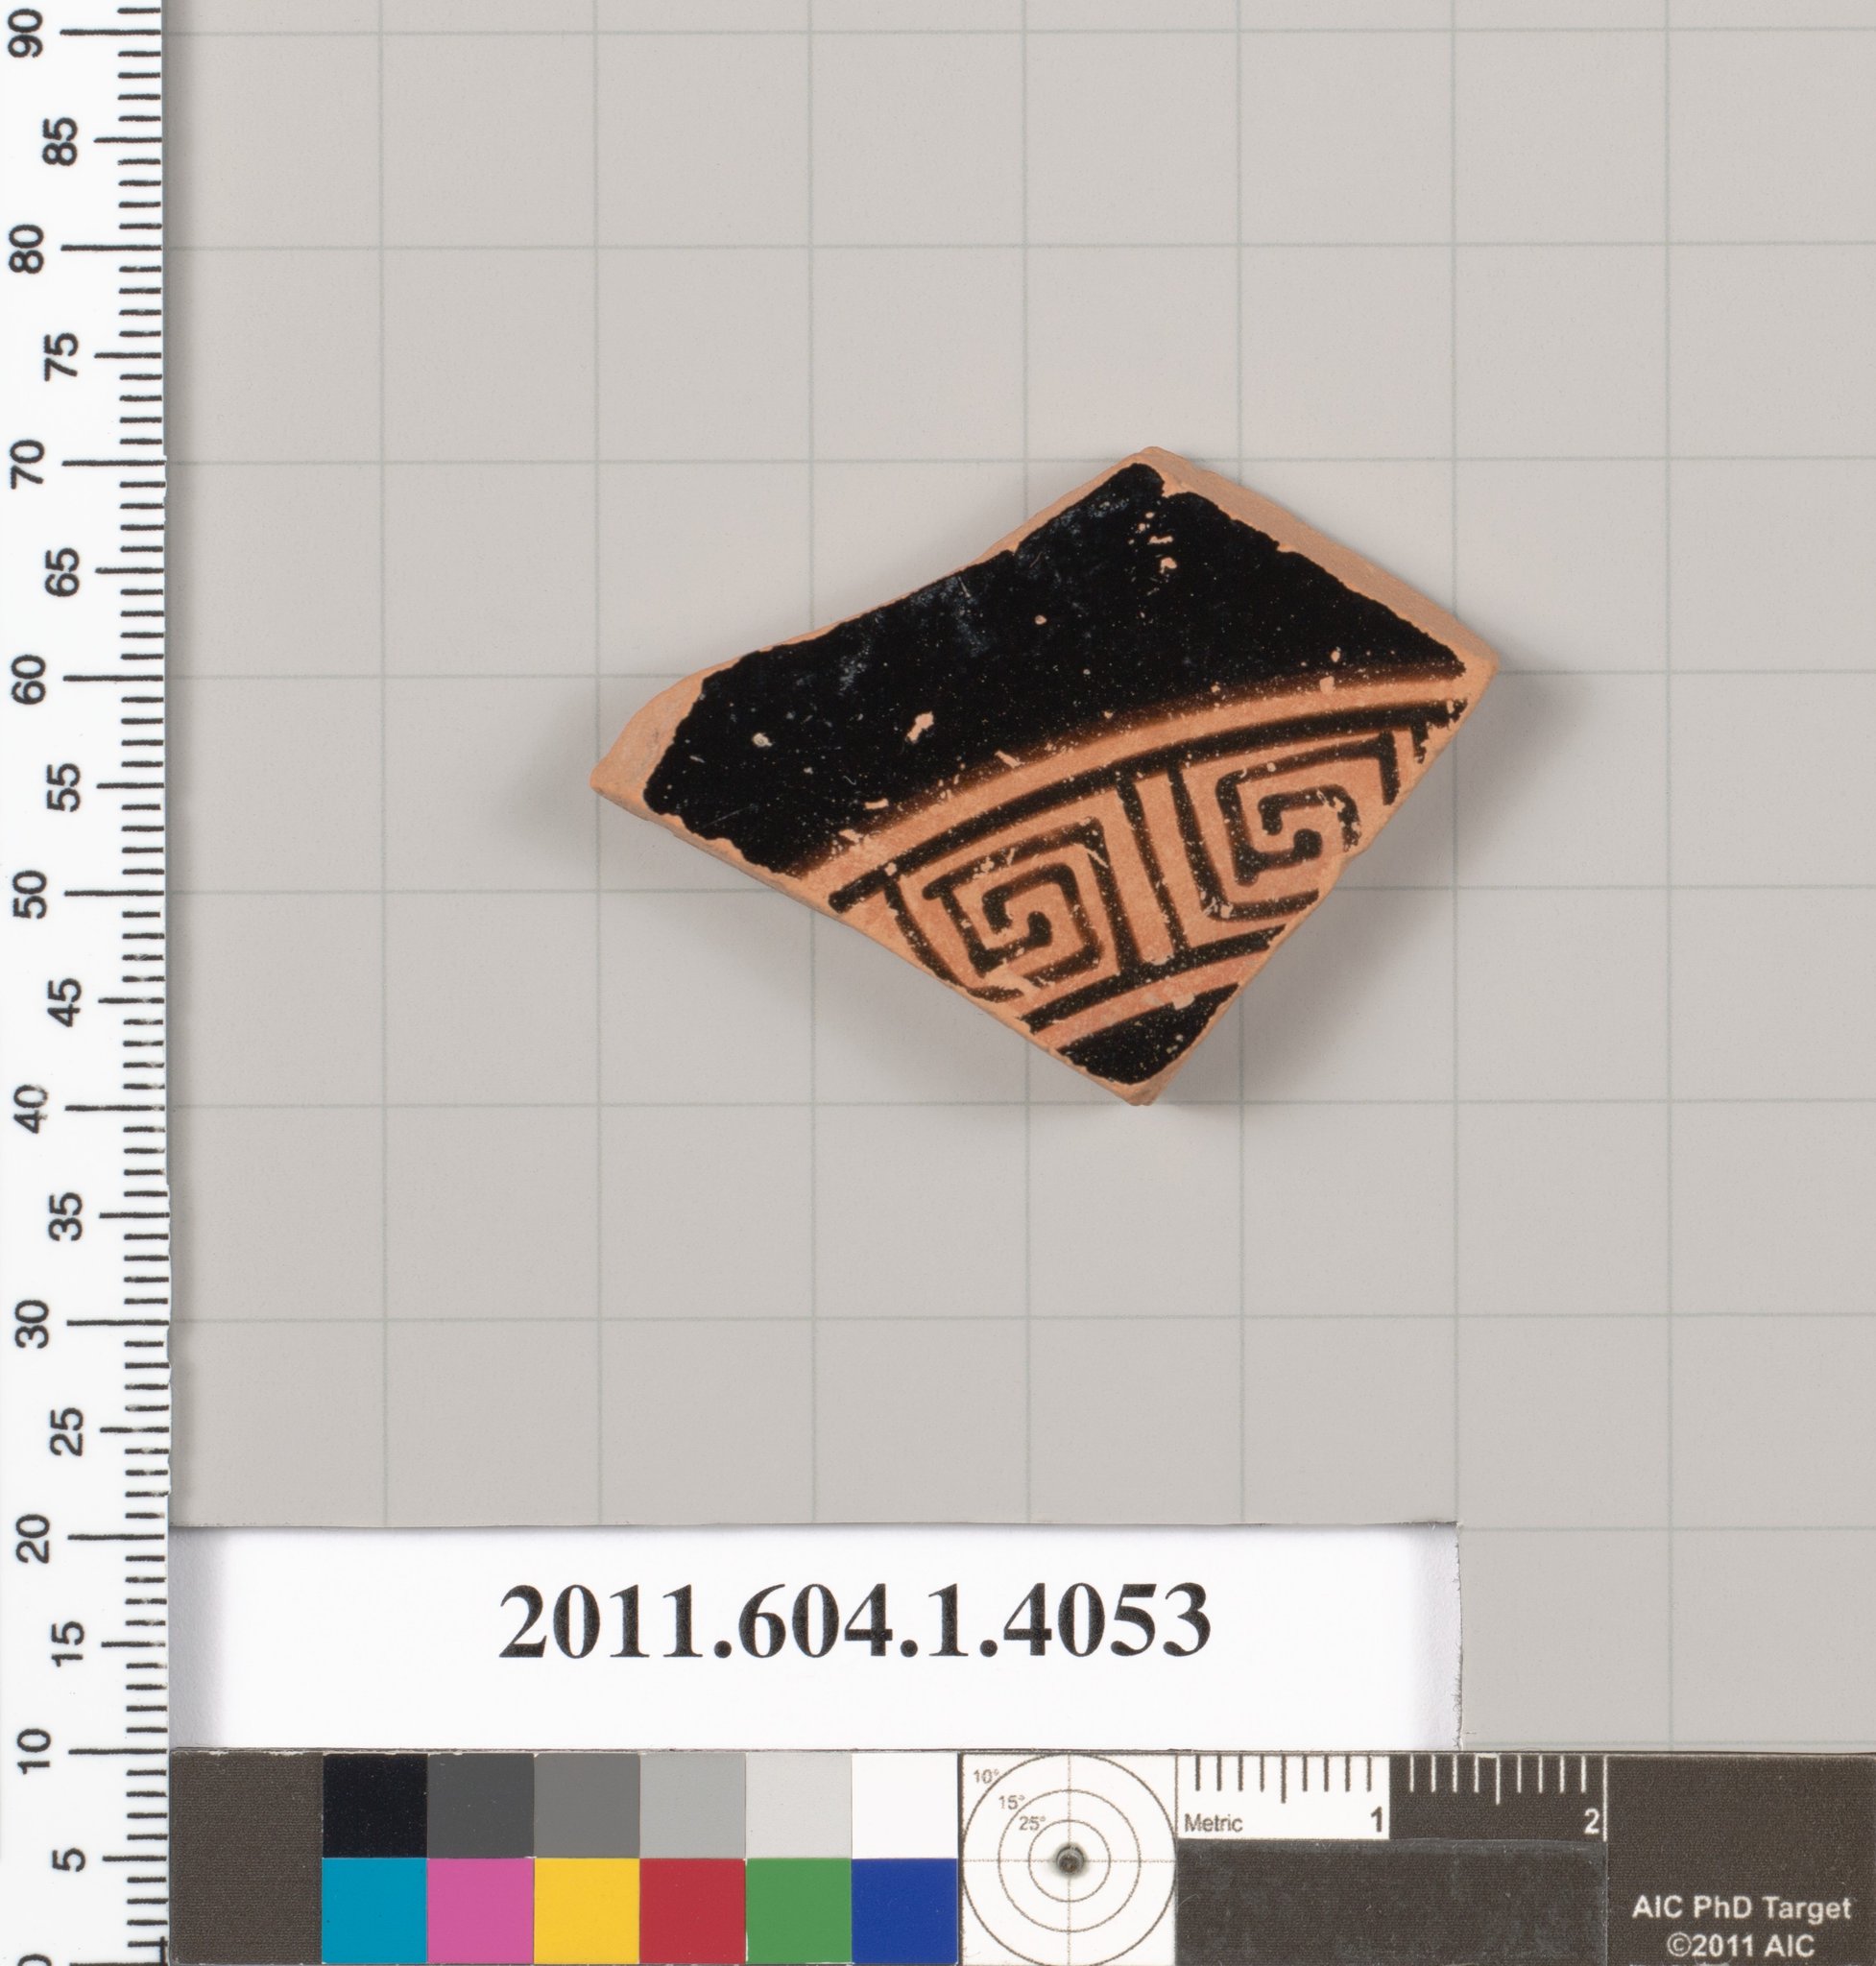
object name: kylix fragment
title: Terracotta fragment of a kylix (drinking cup)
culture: greek, attic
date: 475-451 BCE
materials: terracotta